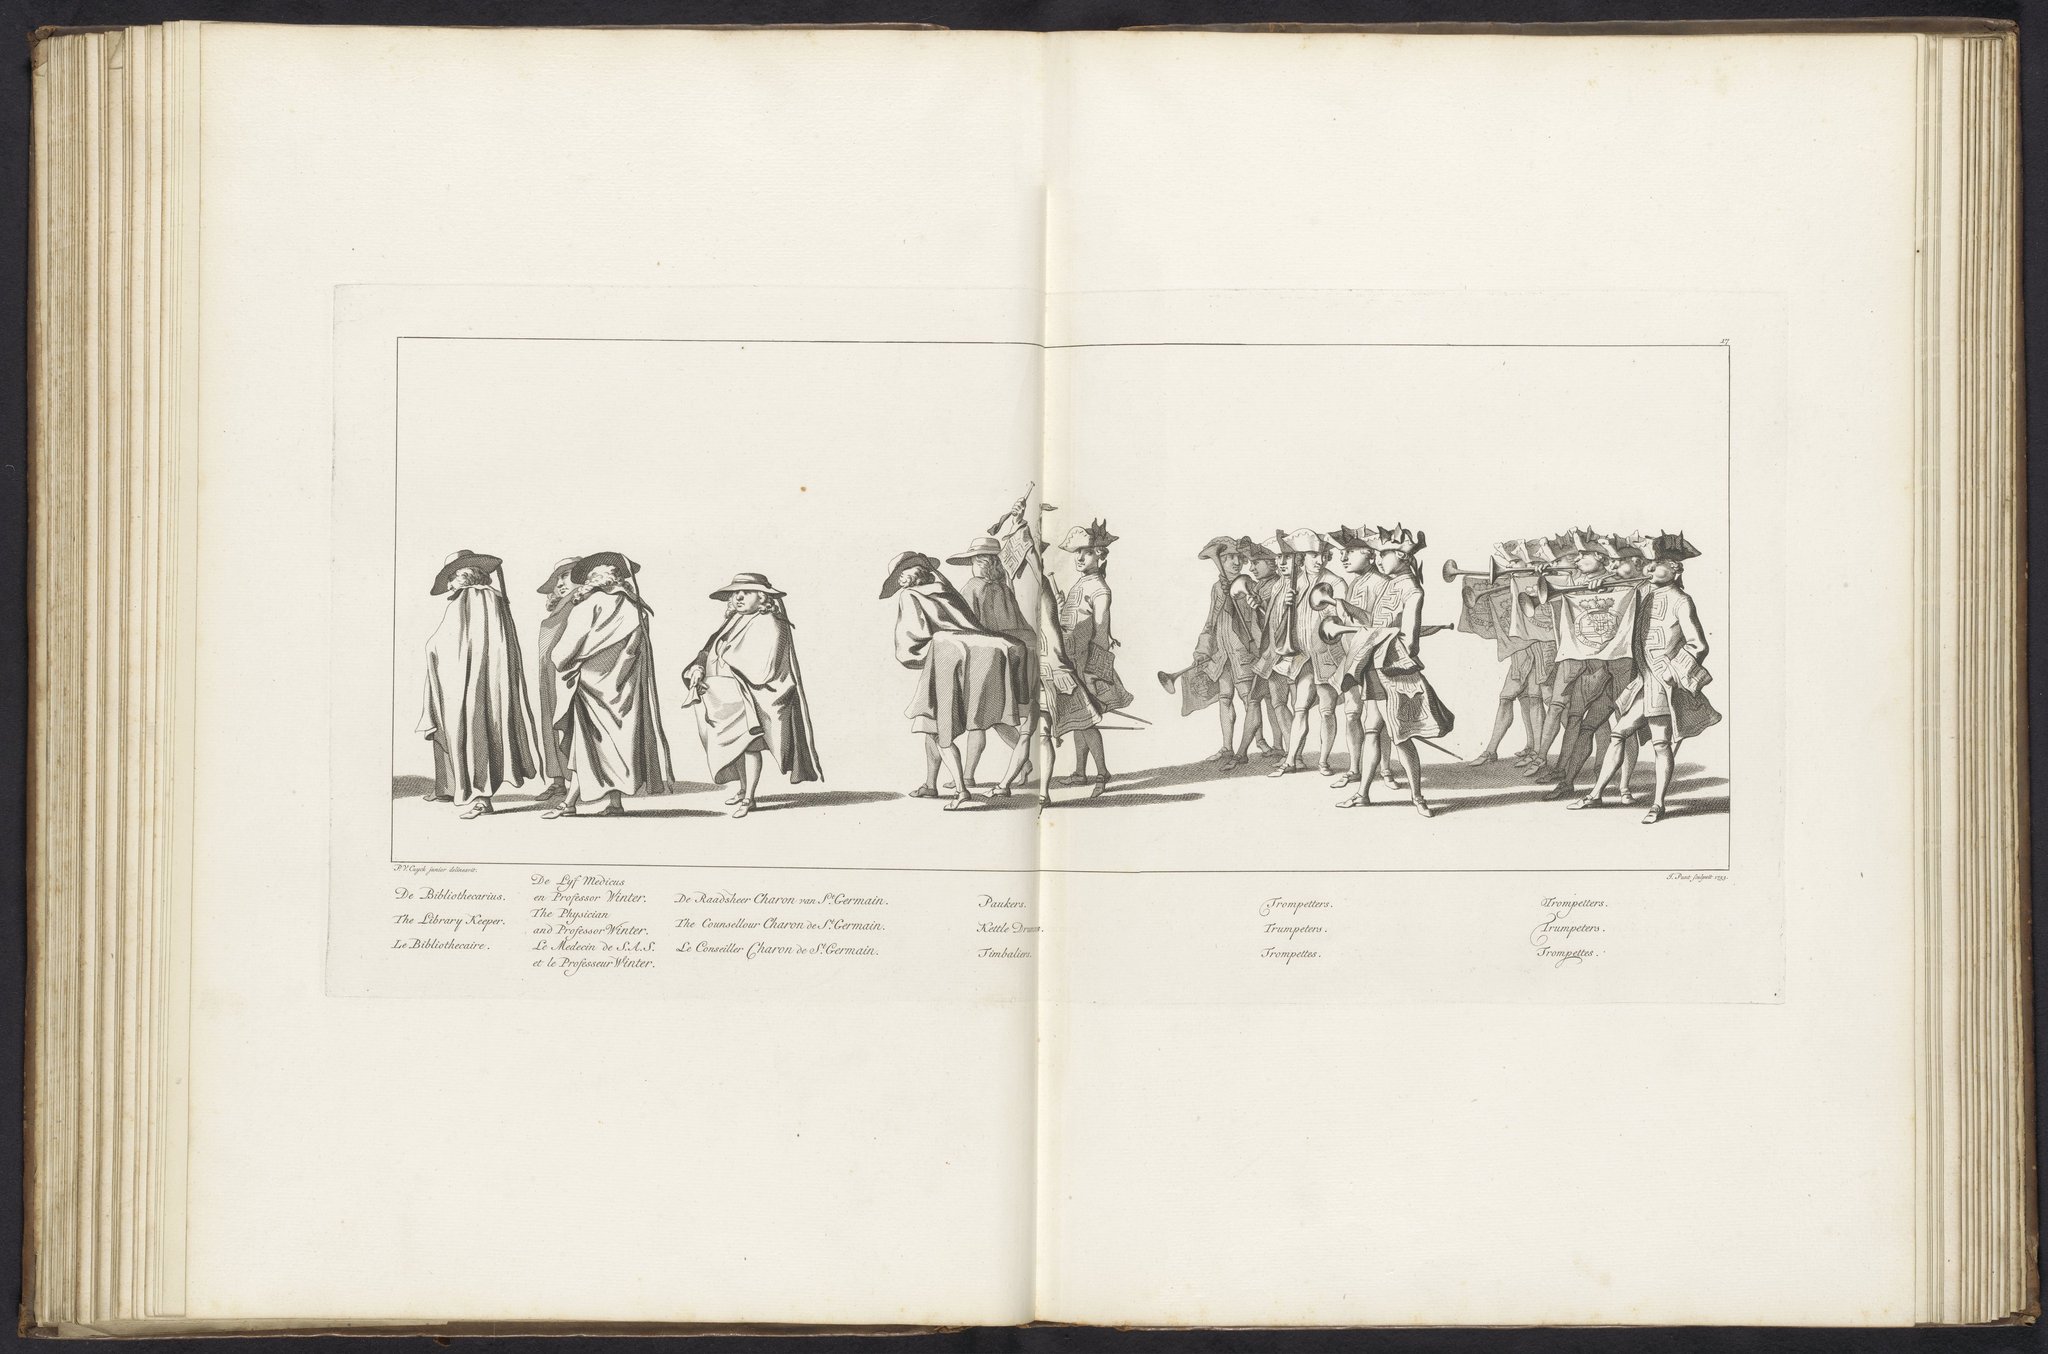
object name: print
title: Lijkstatie van Willem IV, 1752, plaat 17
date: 1753-1755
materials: paper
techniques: engraving, etching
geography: the hague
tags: the hague, willem iv (prins van oranje-nassau), public library (+ scholar, scientist in non-work situations), military music, cortege, funeral procession, royal household; courtiers, retinue, train, delft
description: Leden van de stadhouderlijke hofhouding, waaronder de bibliothecaris en lijfarts, gevolgd door trommelslagers en trompetters. In de marge het onderschrift in Nederlands, Frans en Engels. Onderdeel van een serie van 41 platen van de begrafenisstoet van stadhouder Willem IV te Delft op 4 februari 1752. Genummerd rechtsboven: 17. In de gebonden uitgave van 1755.